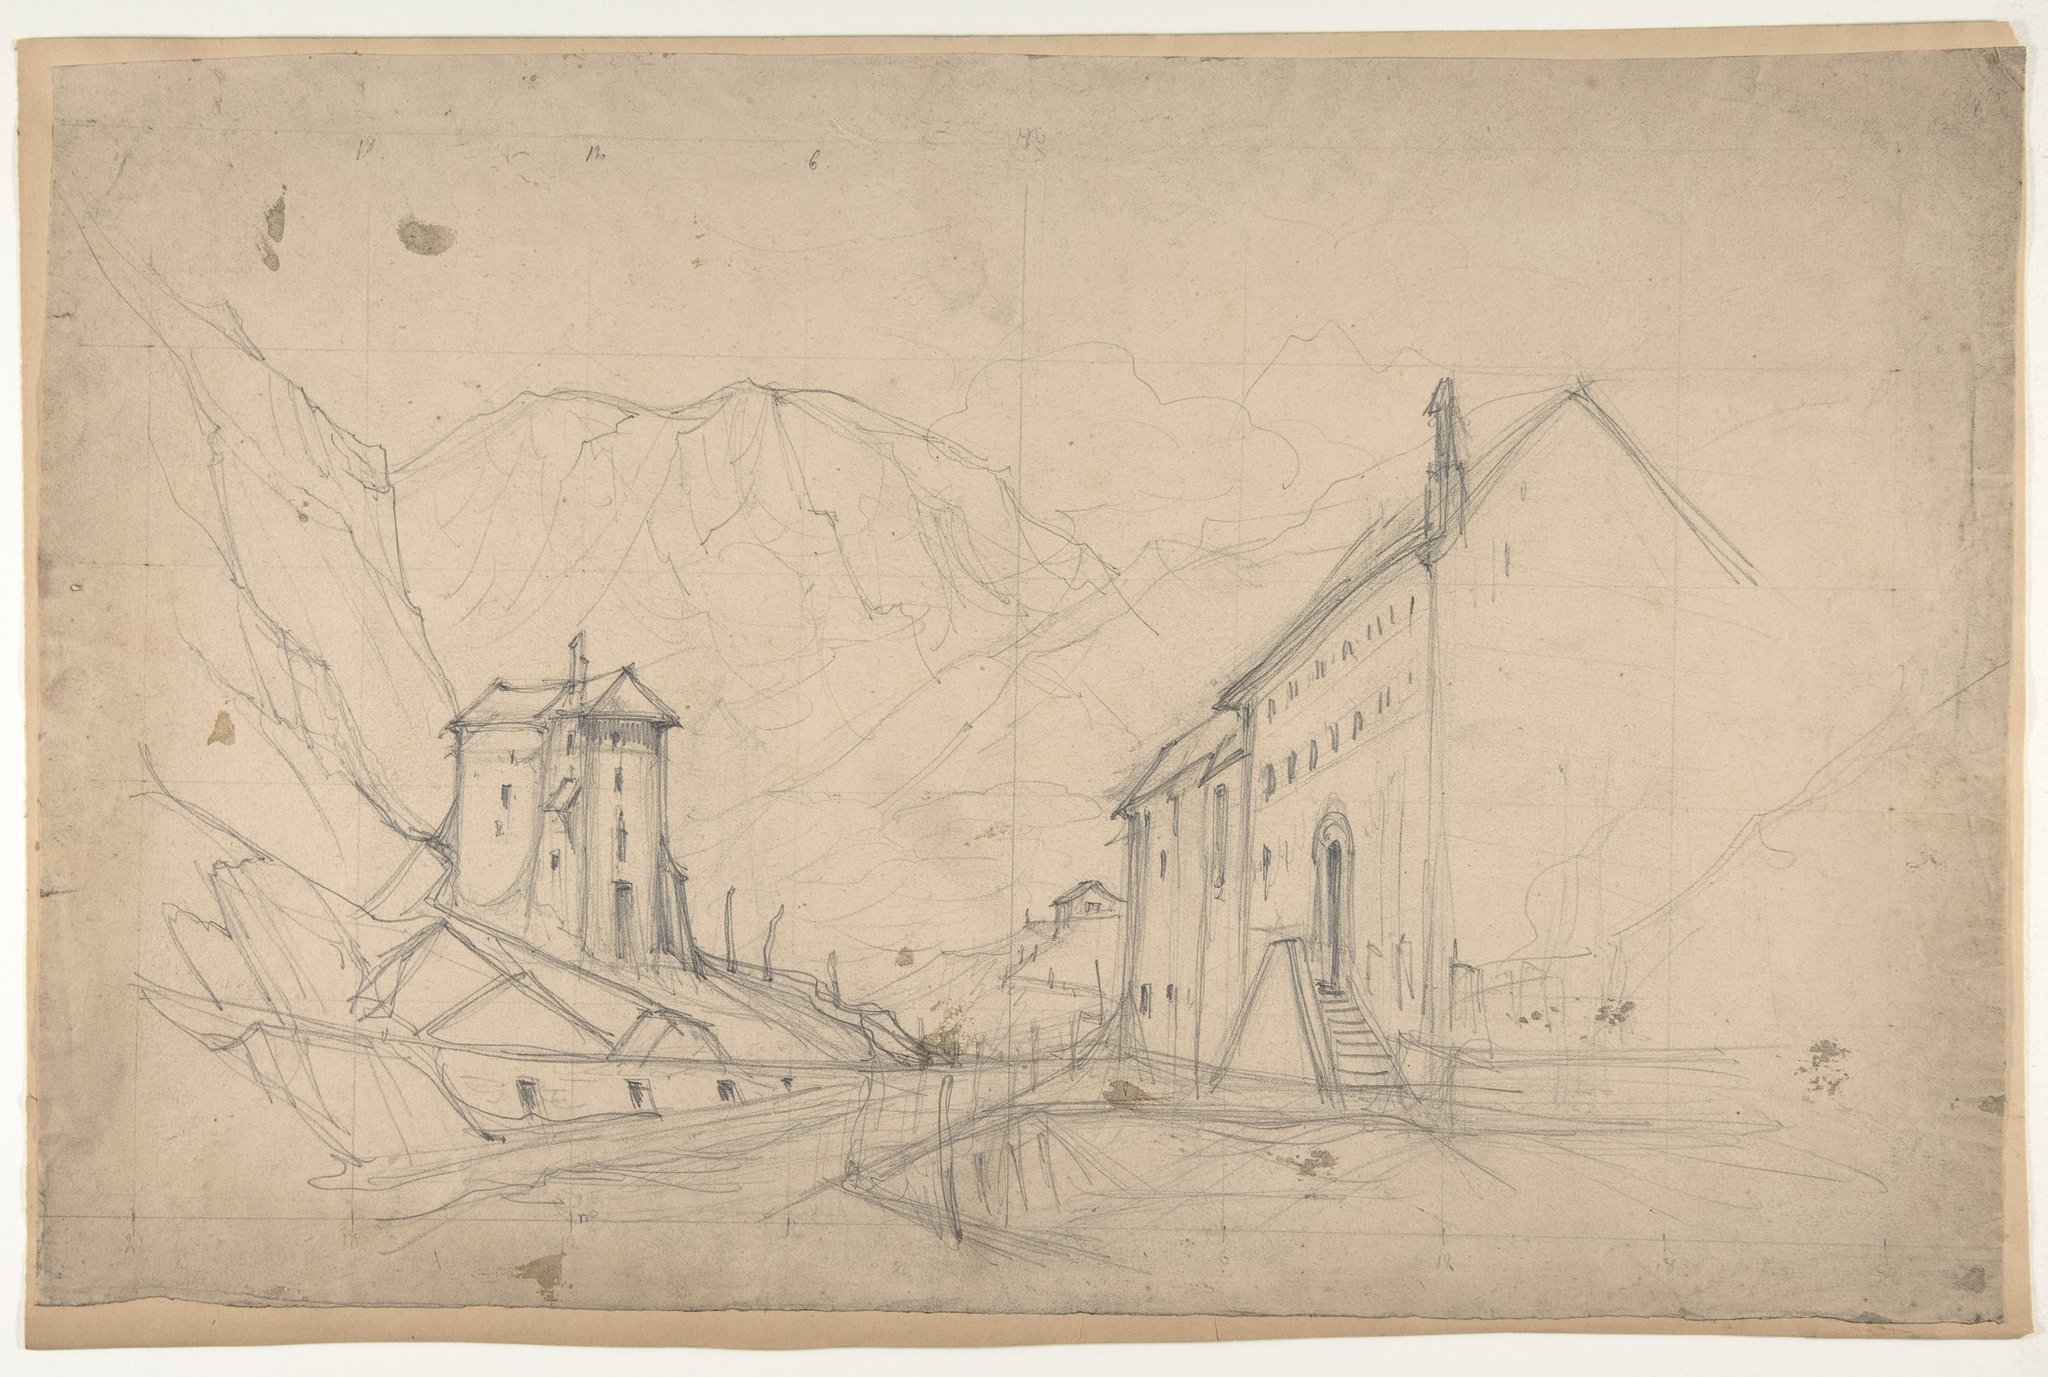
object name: drawing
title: Design for a Stage Set at the Opéra, Paris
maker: eugène cicéri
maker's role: artist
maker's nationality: french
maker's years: 1813-1890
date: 1830-1890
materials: graphite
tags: buildings,mountains,stage design